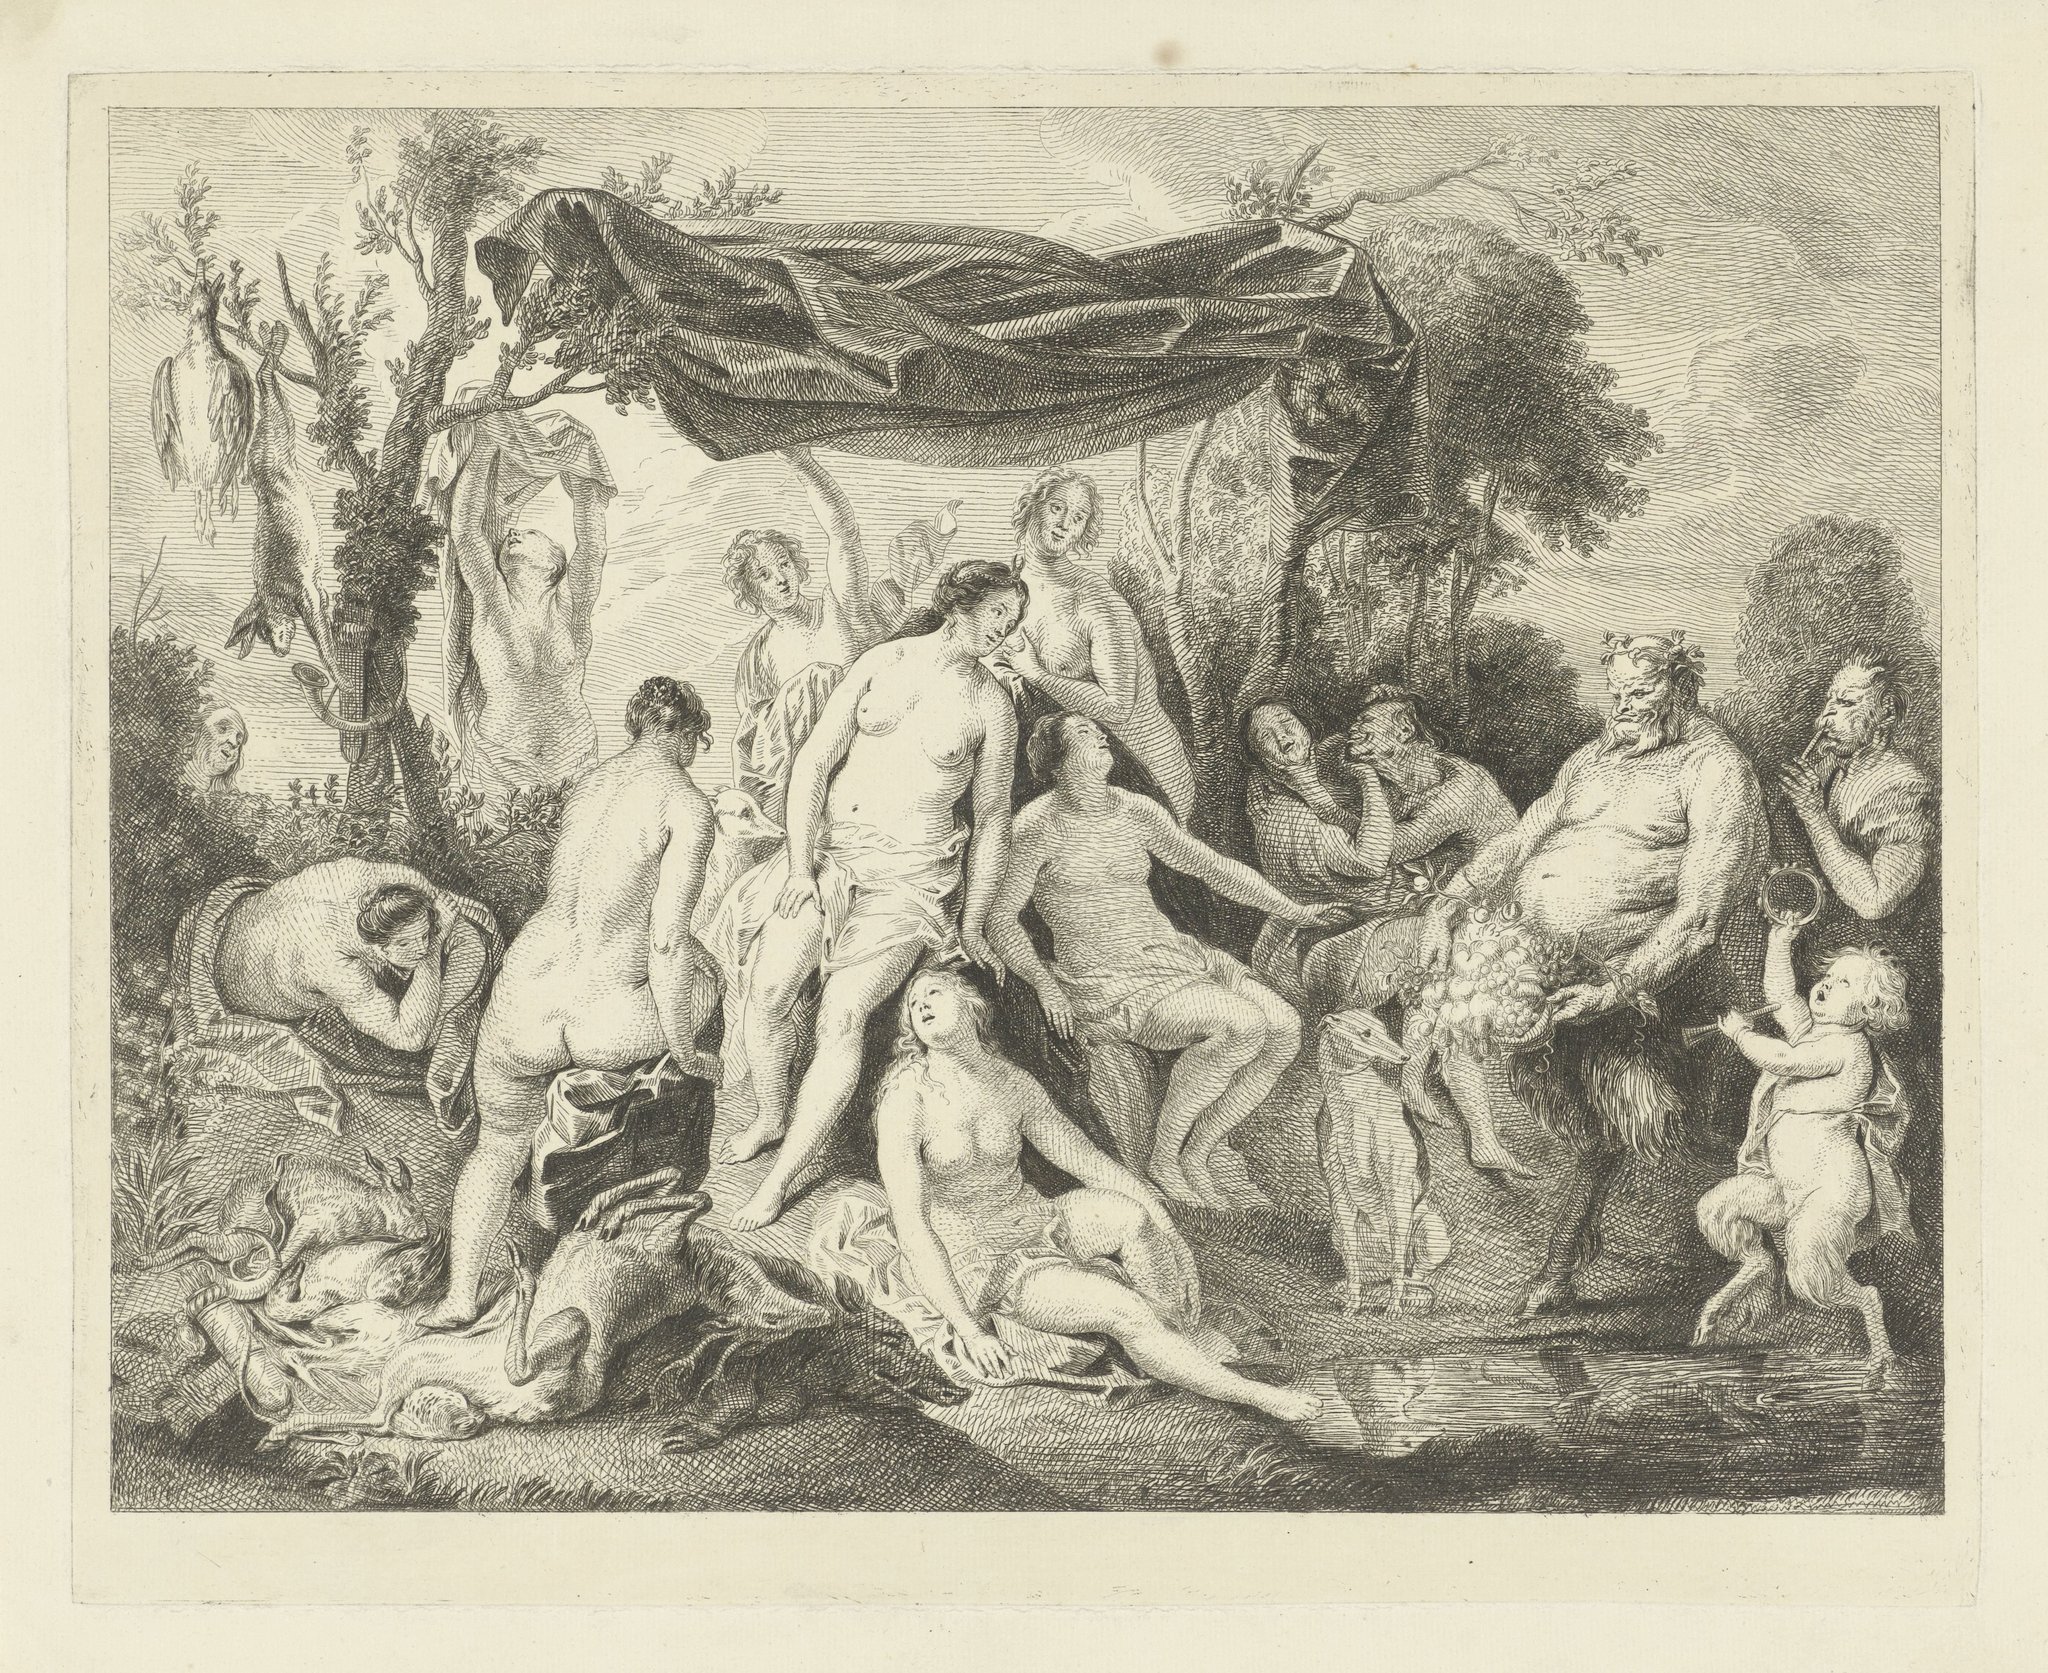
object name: print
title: Badende Diana en Silenus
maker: andries lens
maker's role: print maker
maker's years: 1739-1822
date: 1749-1822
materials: paper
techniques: etching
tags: (story of) silenus, diana bathing with her nymphs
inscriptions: collector's mark: Lugt 240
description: Badende Diana met haar metgezellinnen. Rechts staat Silenus met trossen druiven in zijn handen. Silenus wordt omringd door twee saters die muziek maken, een derde probeert een nimf te kussen. Links op de voorgrond ligt geschoten wild.